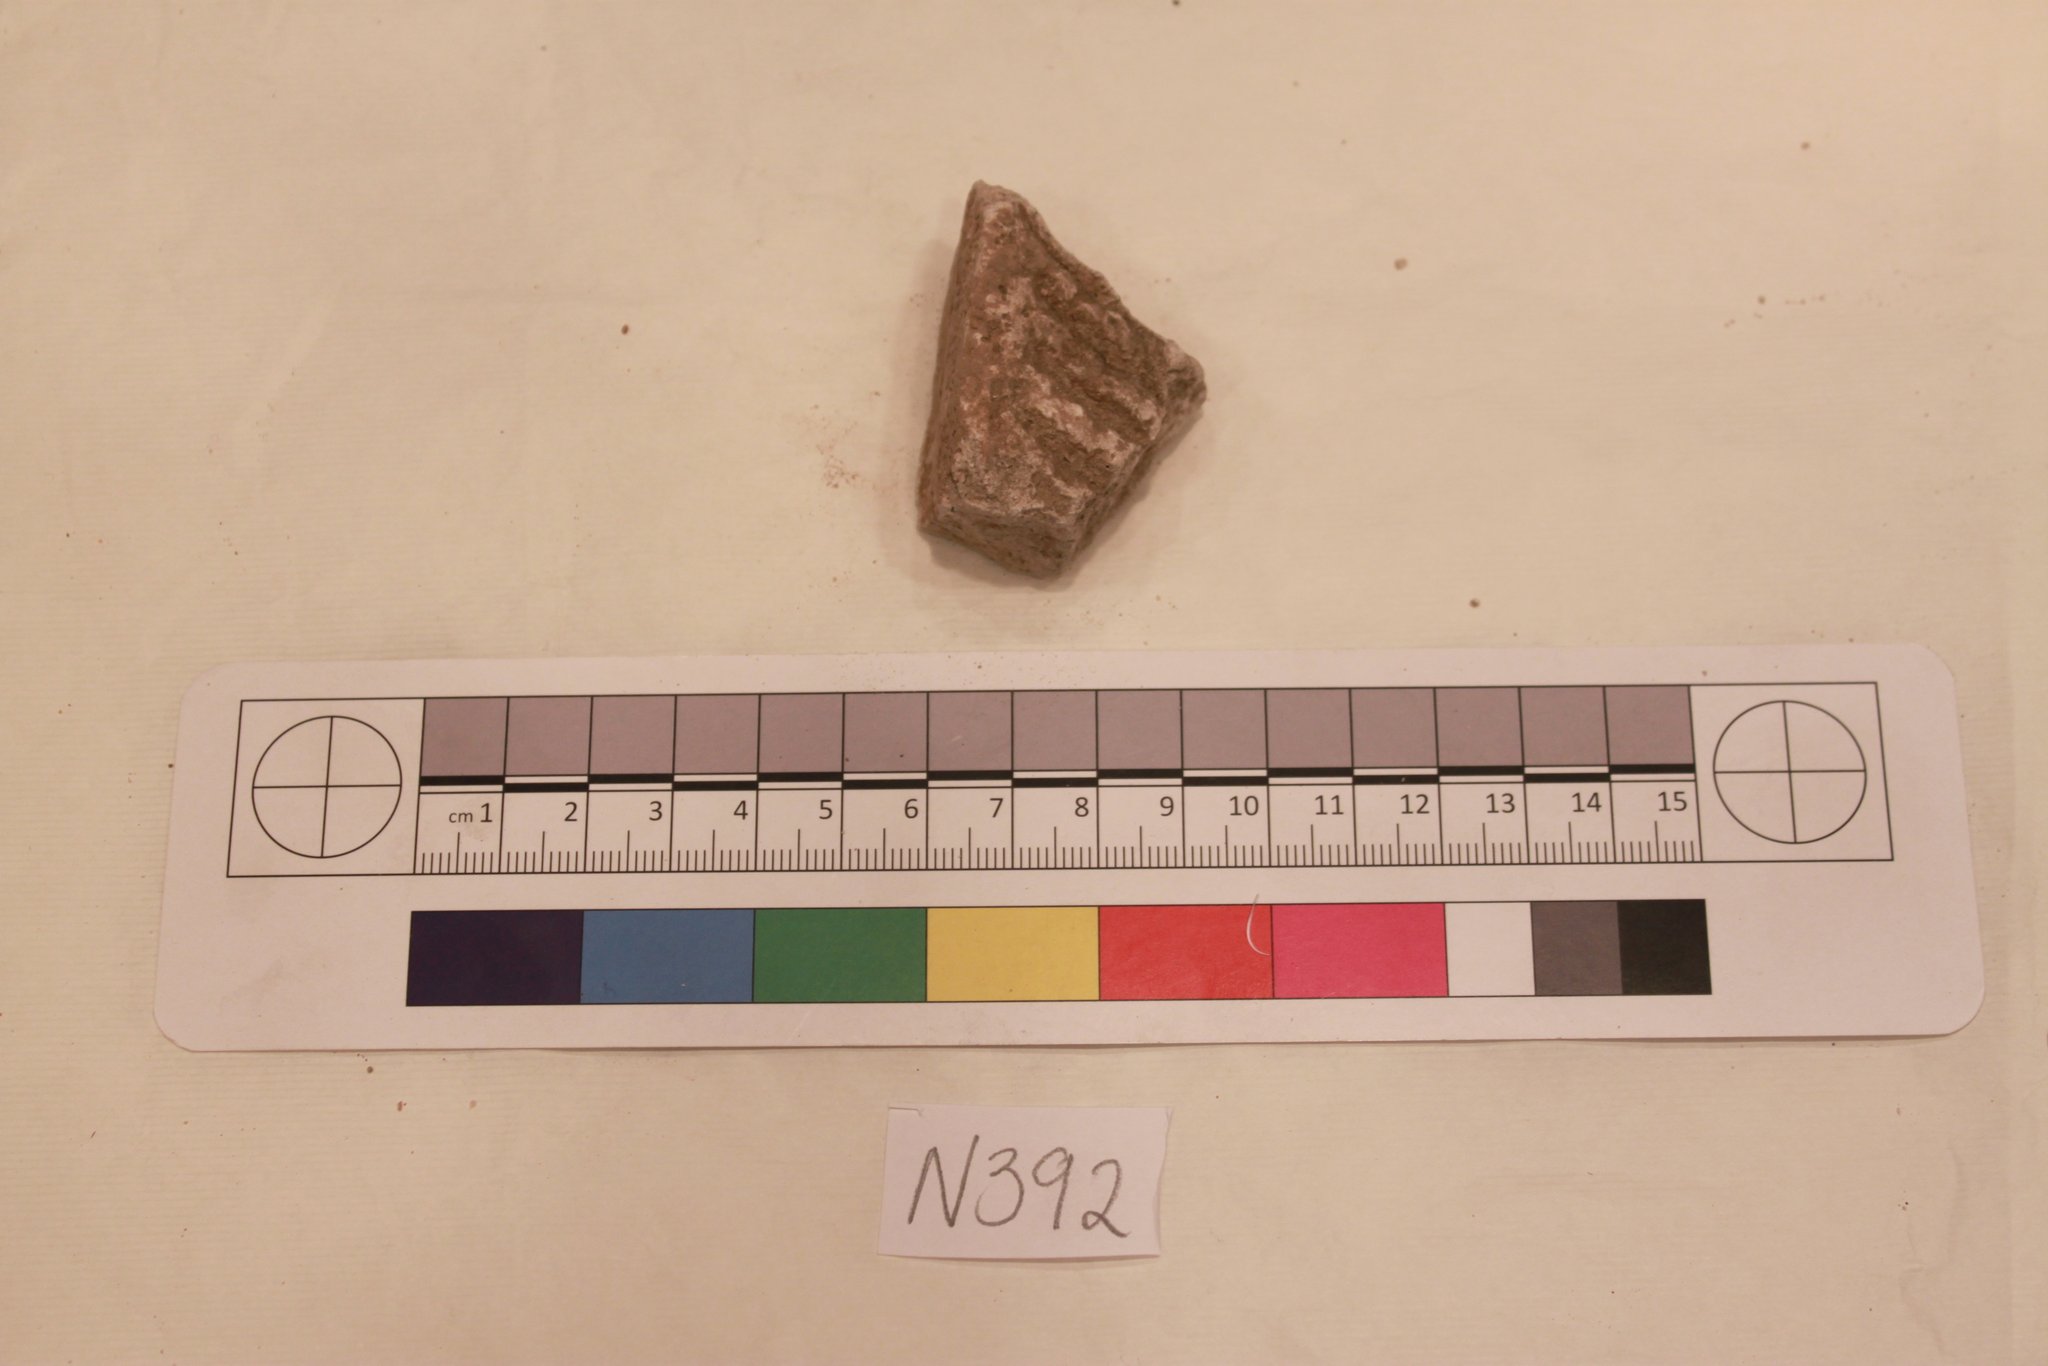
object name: fragment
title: Stucco Fragment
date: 701-1200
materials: plaster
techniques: carving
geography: iran